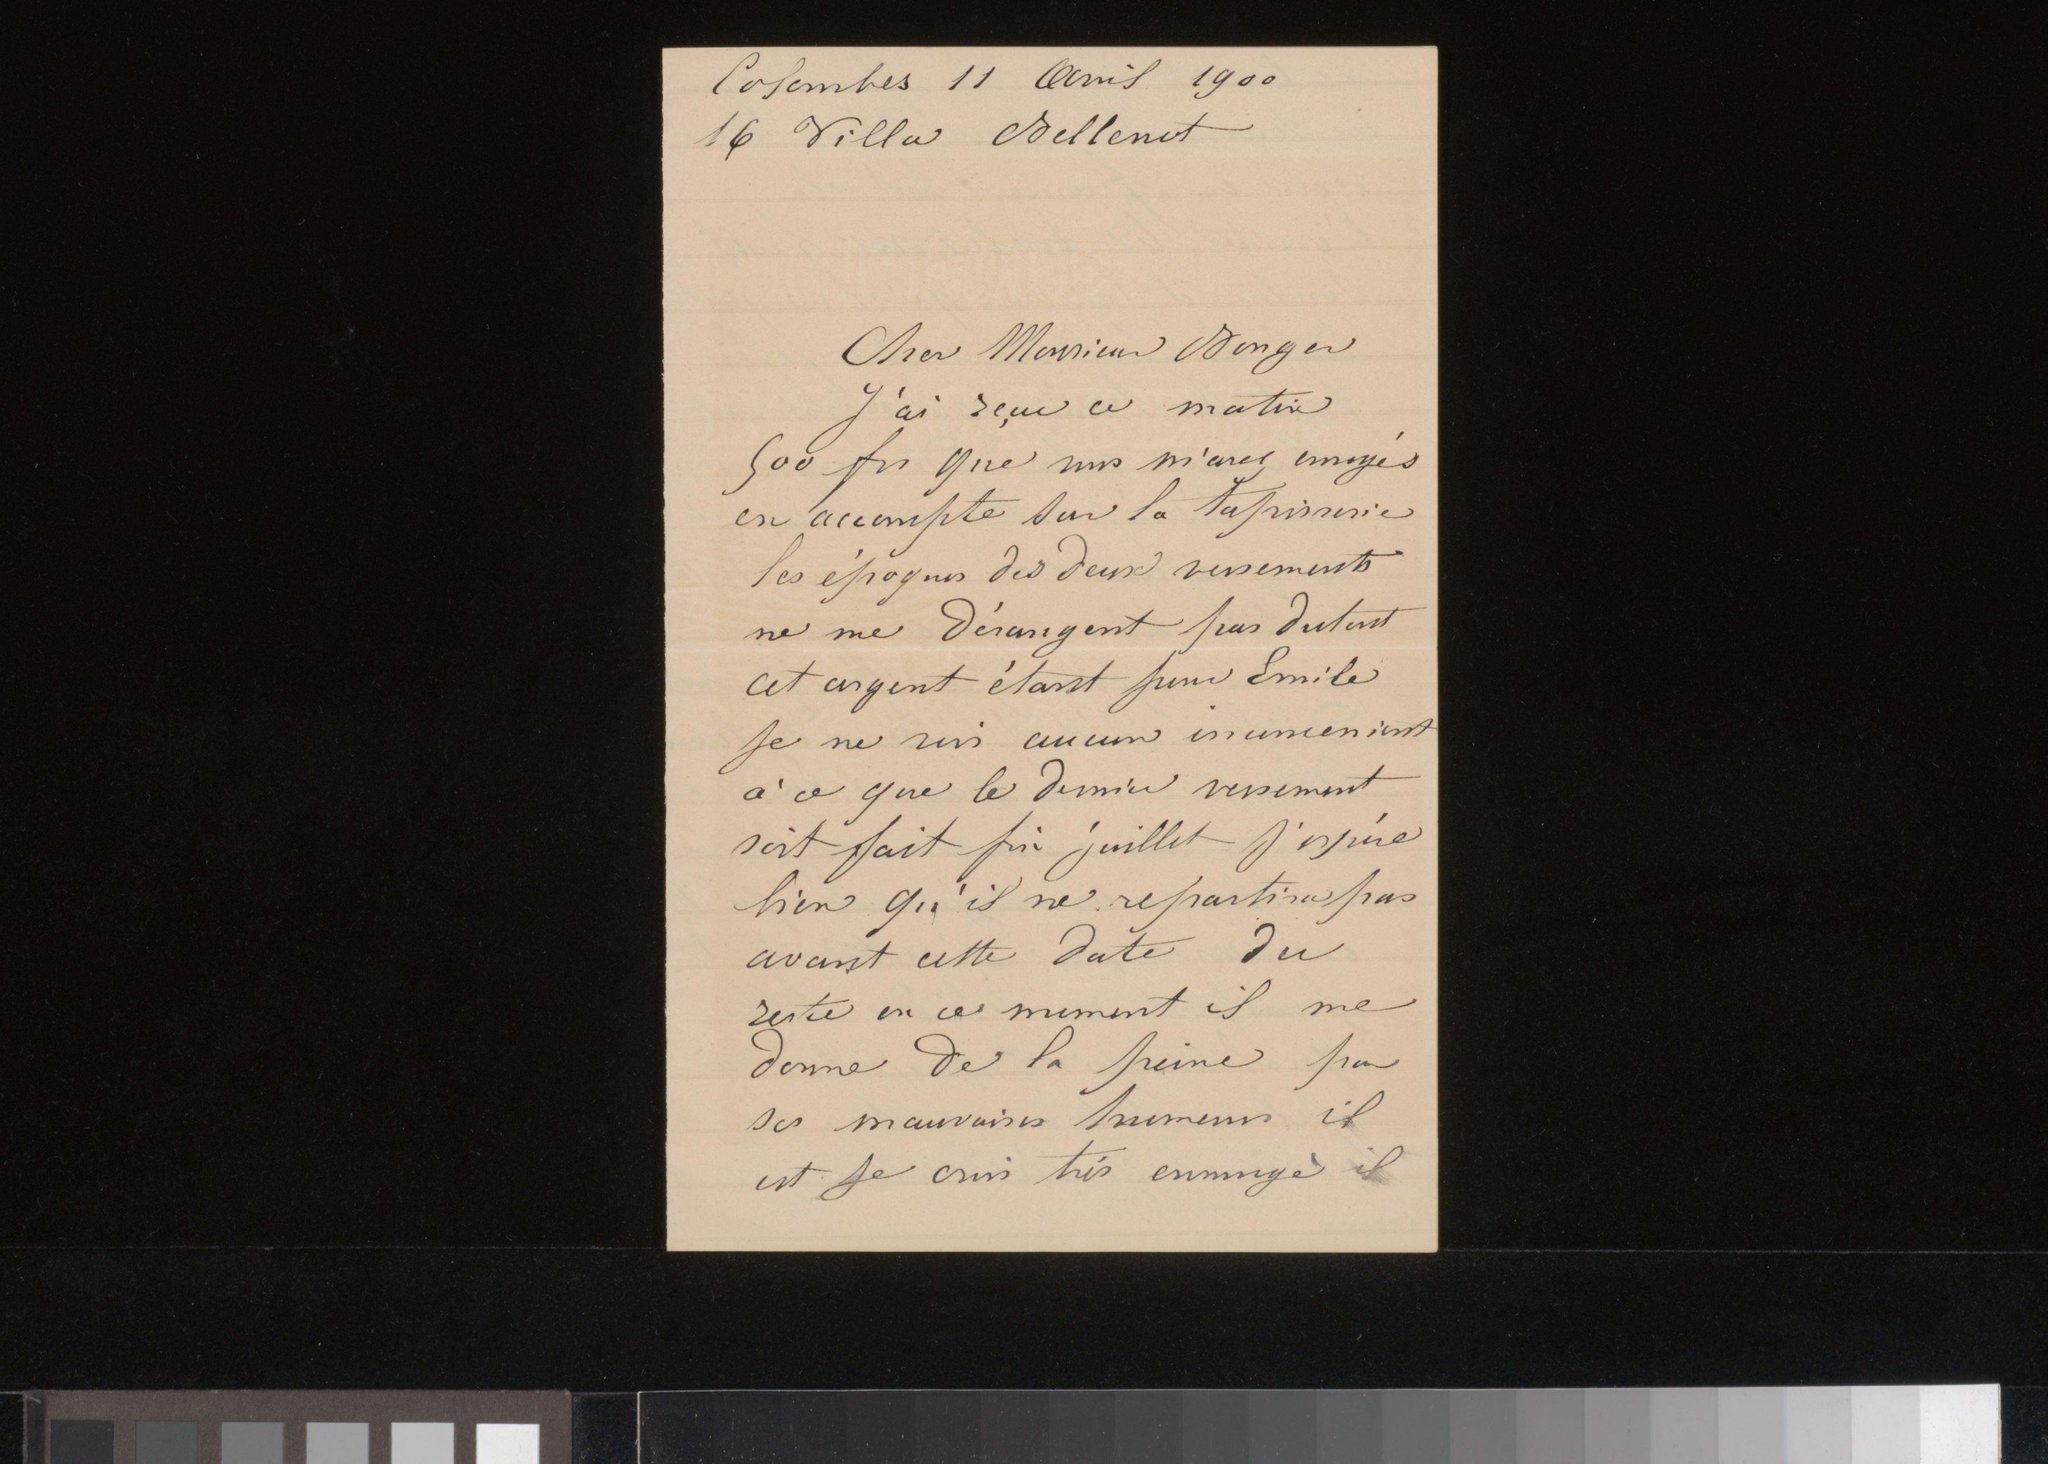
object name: letter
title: Brief aan Andries Bonger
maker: héloïse bernard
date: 1900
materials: ink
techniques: pen, writing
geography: colombes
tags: paris, émile bernard, andries bonger, applied arts, arts and crafts; industrial design, painting (including book-illumination, miniature-painting), money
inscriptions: watermark